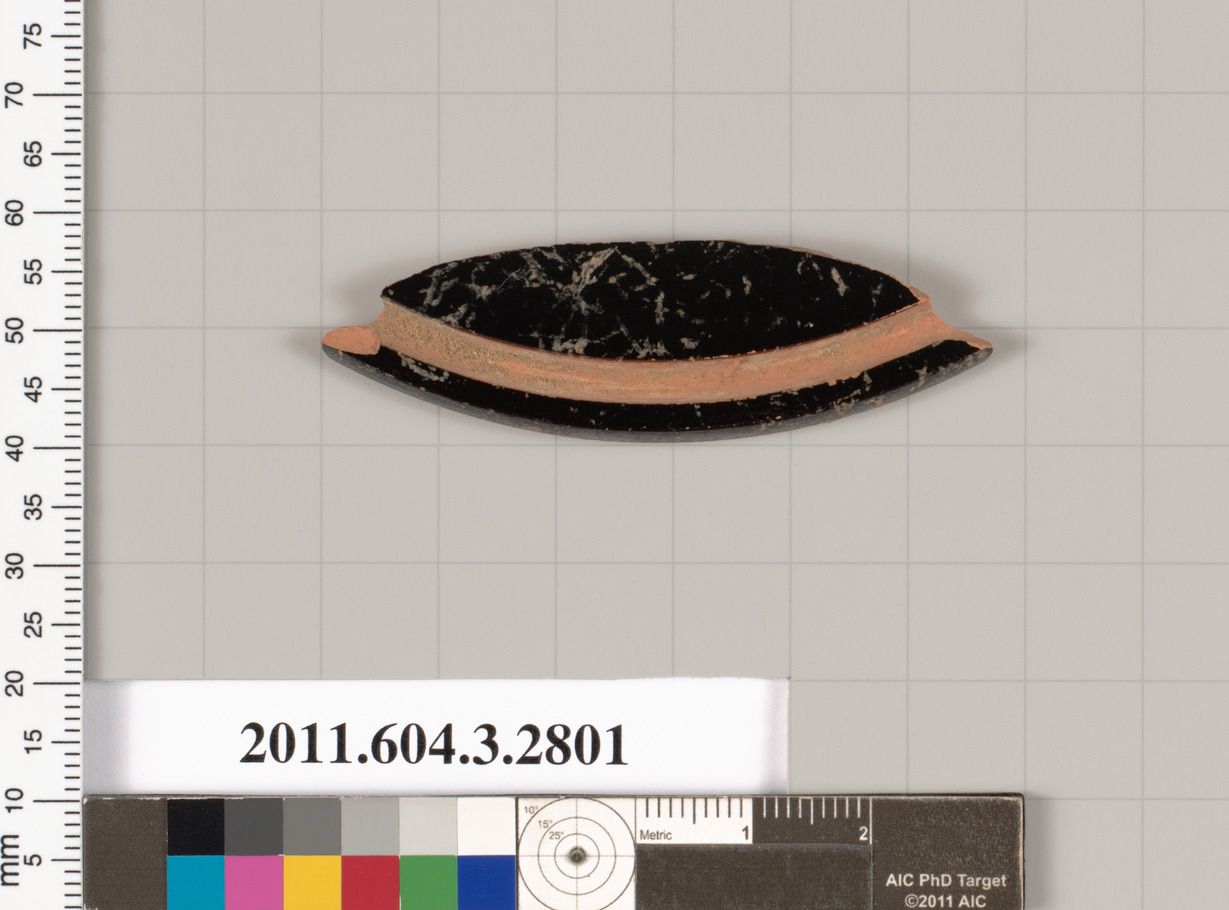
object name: plate fragment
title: Terracotta fragment of a plate?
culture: greek, attic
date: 600-401 BCE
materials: terracotta